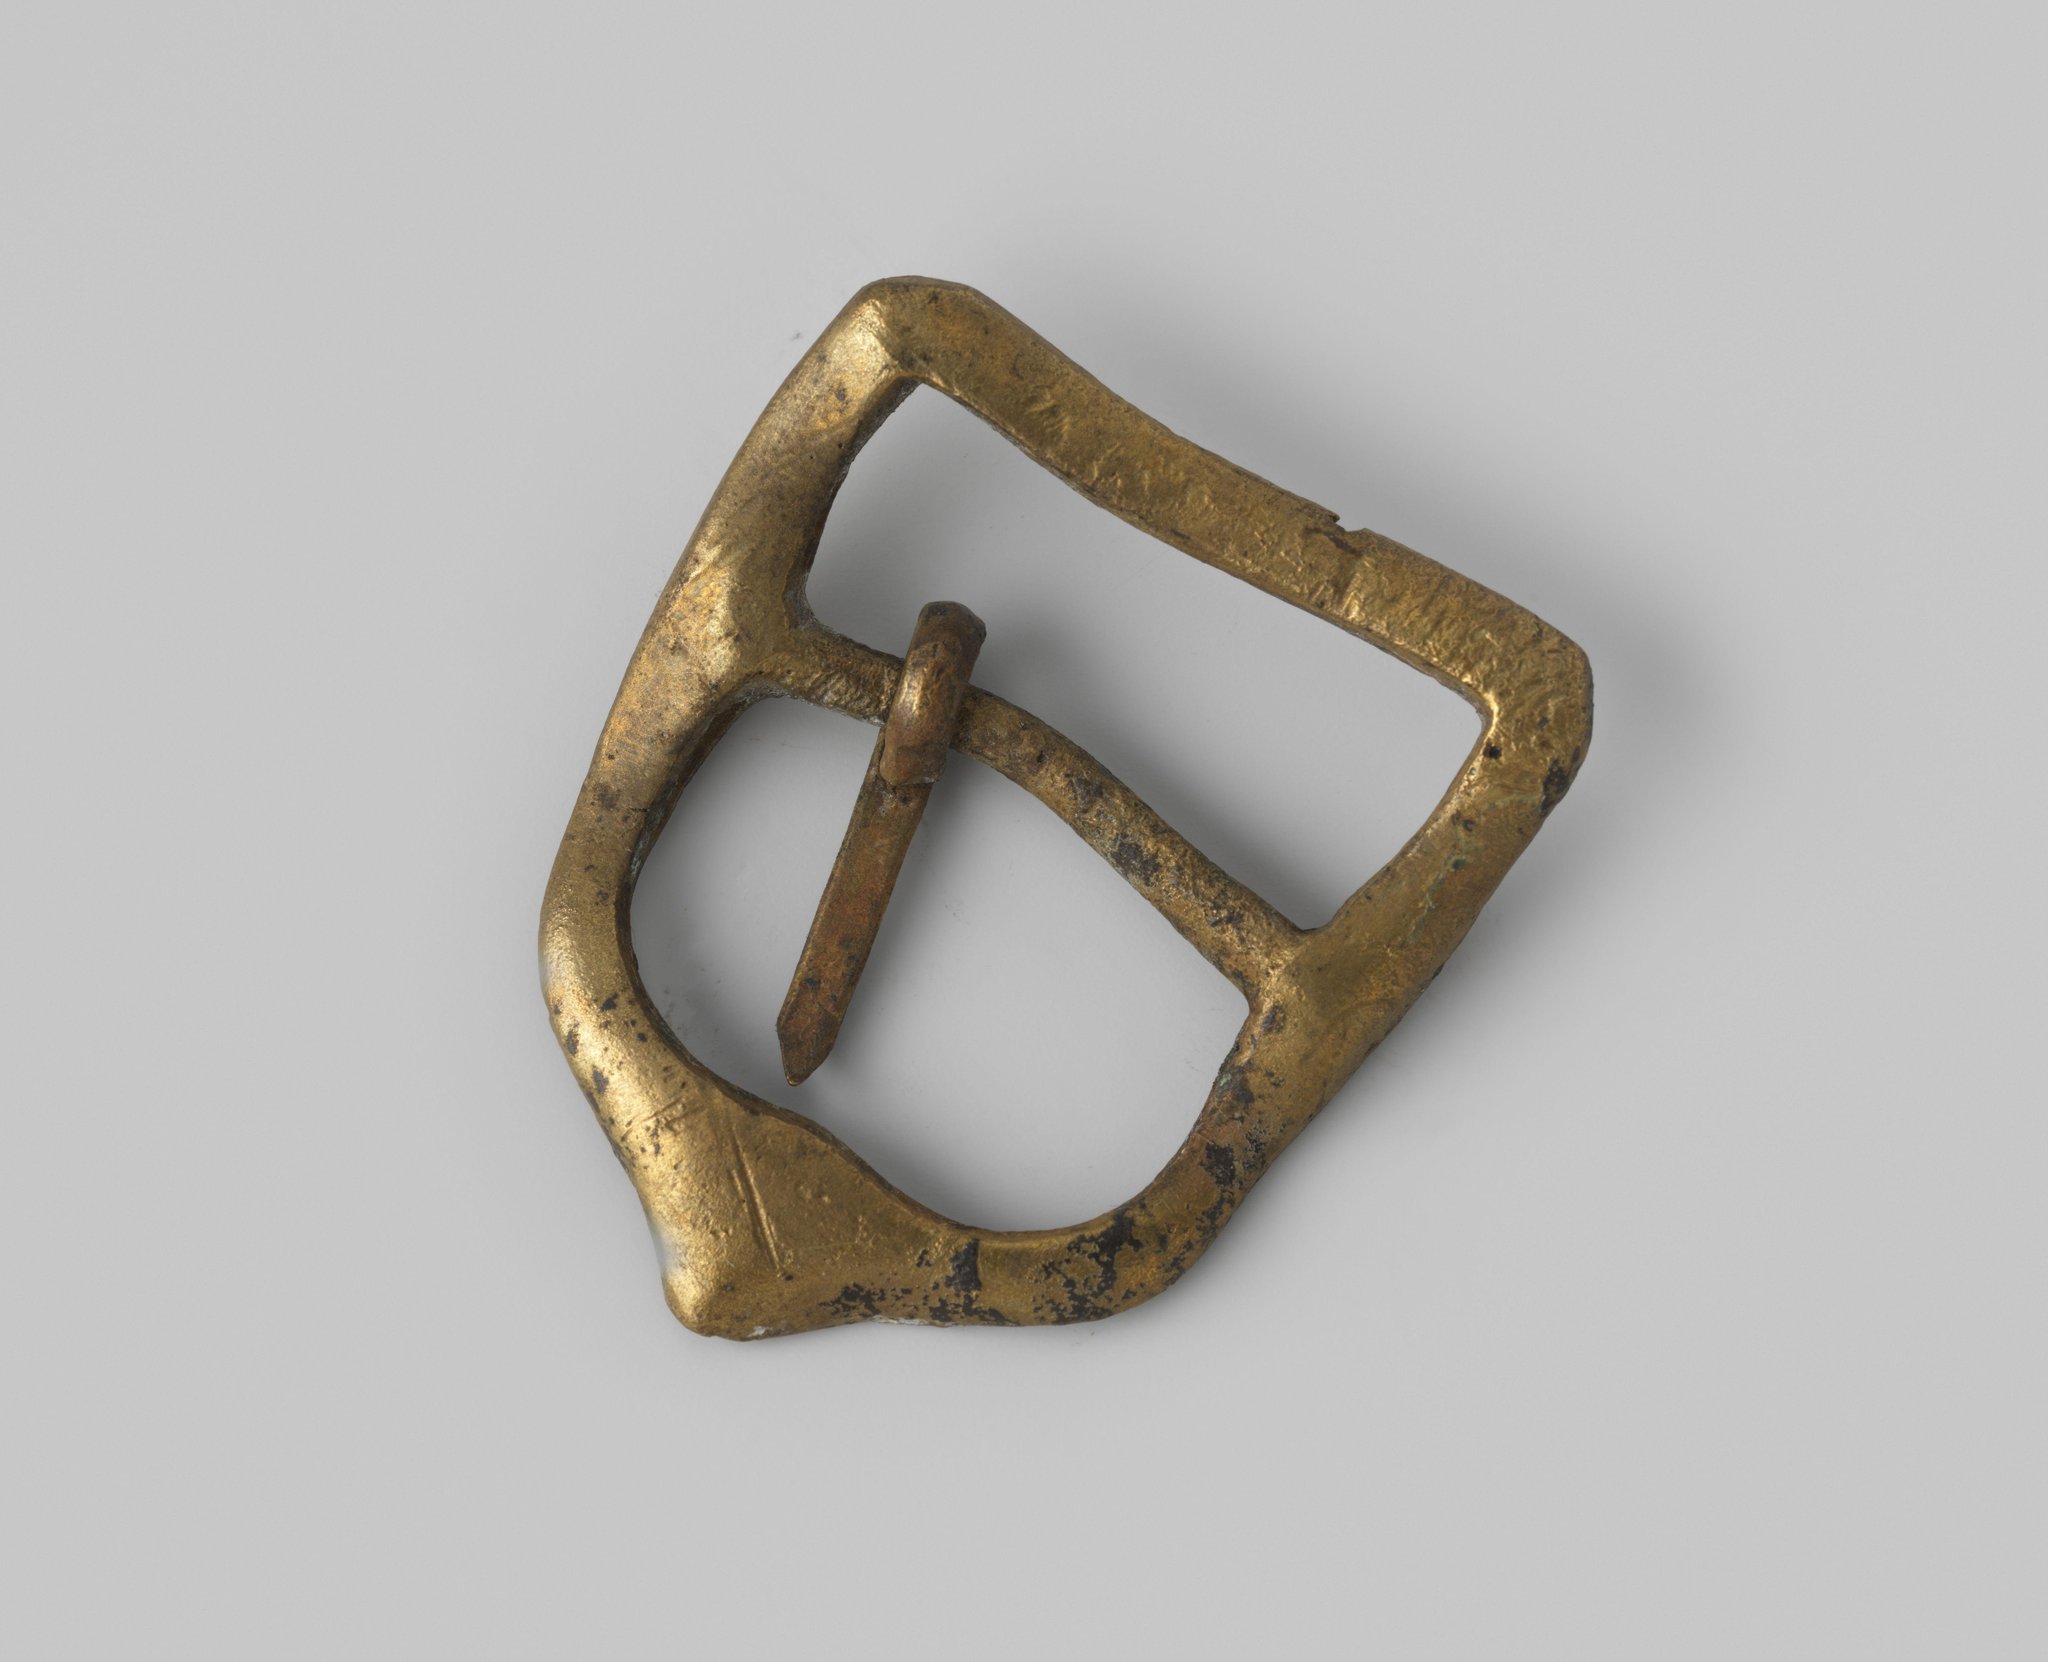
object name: belt buckle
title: Riemgesp uit het wrak van de Oost-Indiëvaarder Hollandia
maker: Anonymous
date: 1700-1743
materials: copper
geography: netherlands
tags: verenigde oostindische compagnie, hollandia (schip), annet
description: D-shaped with pointed side, id. NG 1980-27H384, belt buckle.